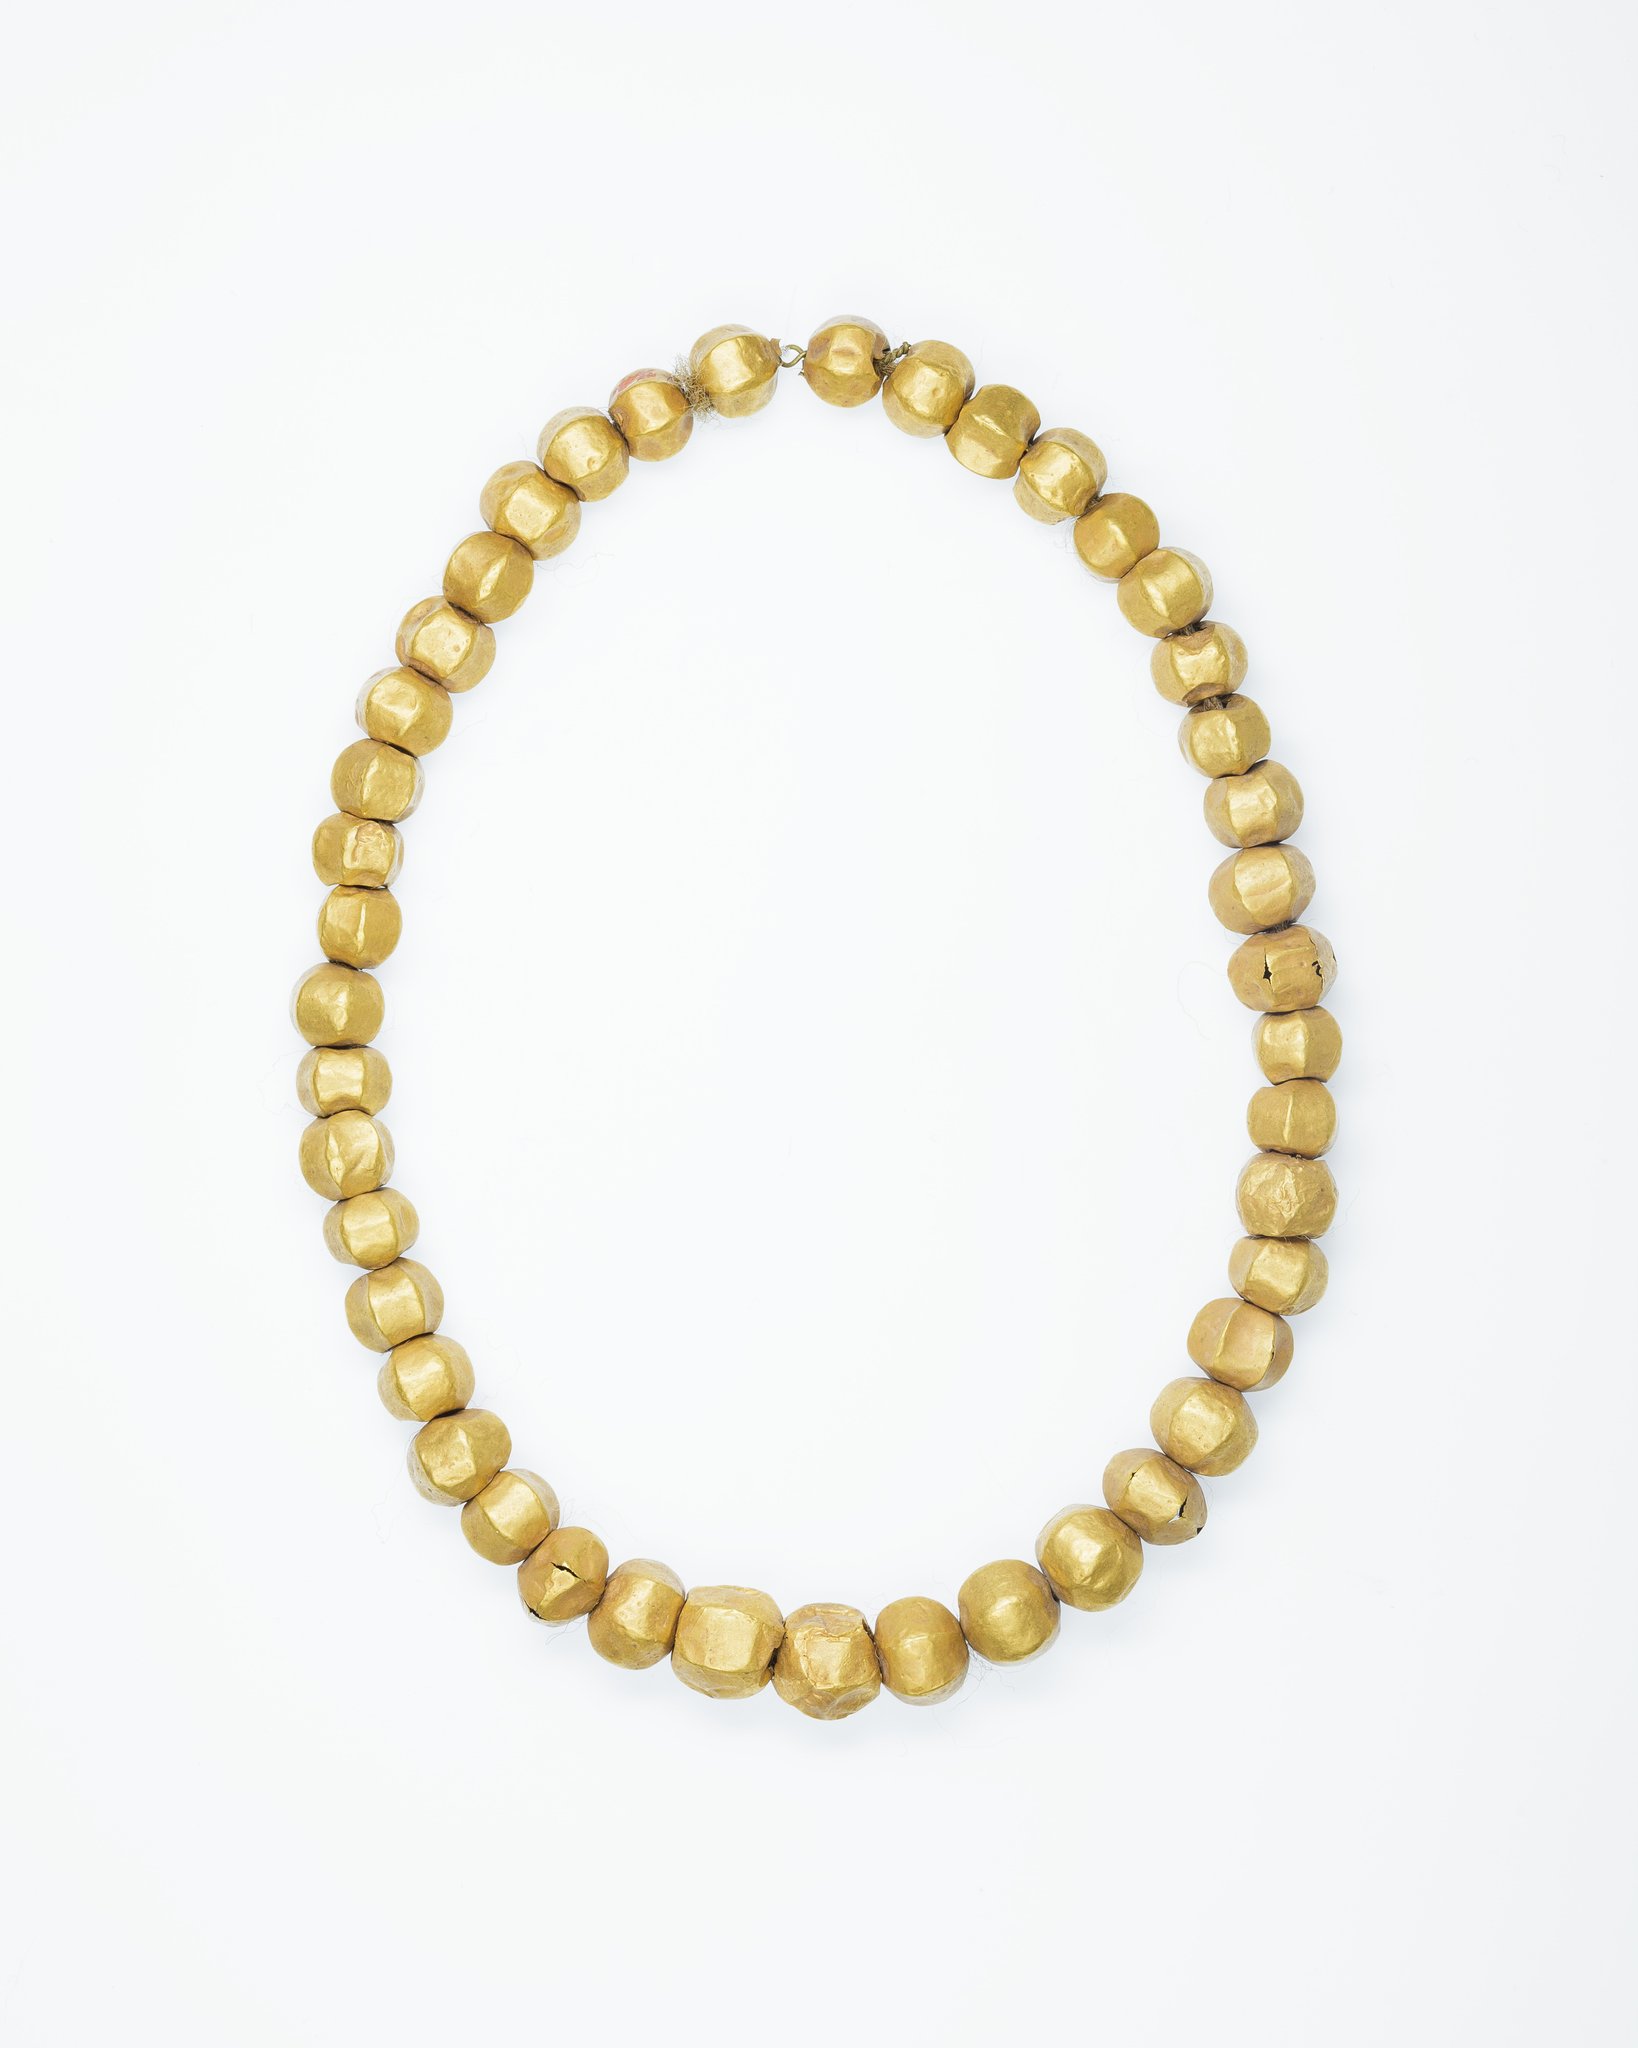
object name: string of 43 bead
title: String of 43 beads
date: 304-30 BCE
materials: gold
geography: egypt